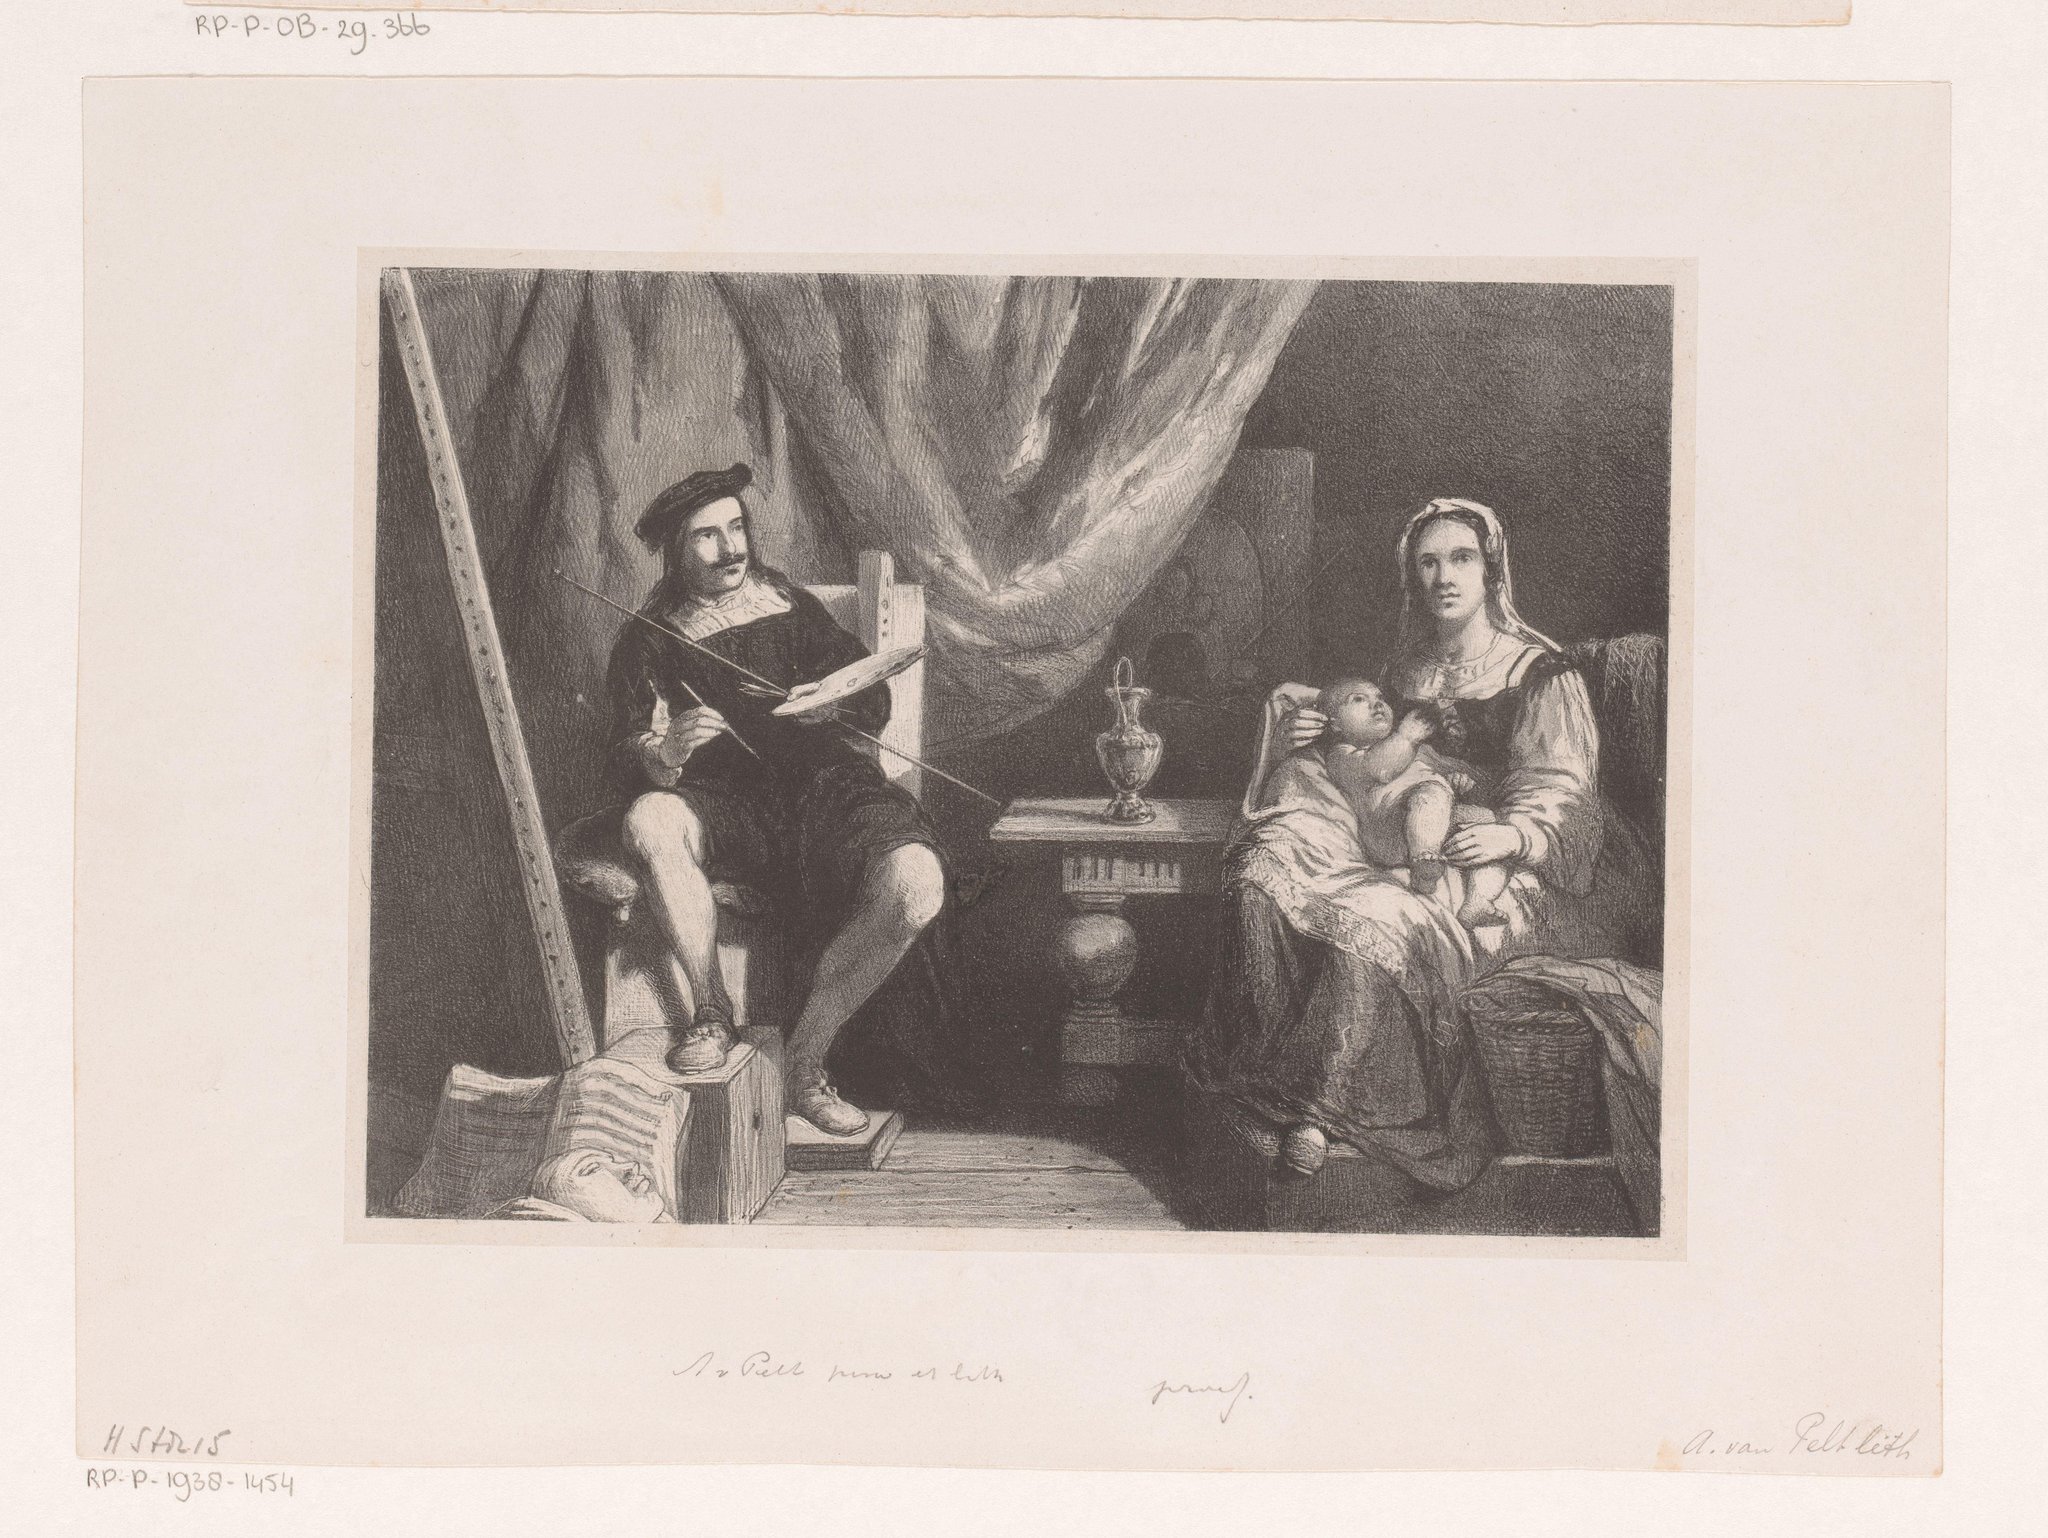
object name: print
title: Schilder met vrouw en kind in zijn atelier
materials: paper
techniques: lithograph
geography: the hague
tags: workshop, studio ~ painter, painter at work, in his studio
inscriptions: collector's mark: Lugt 2228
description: In zijn atelier zit een schilder met schilderspalet en stok achter een doek en kijkt naar zijn model: een vrouw met kind op schoot.